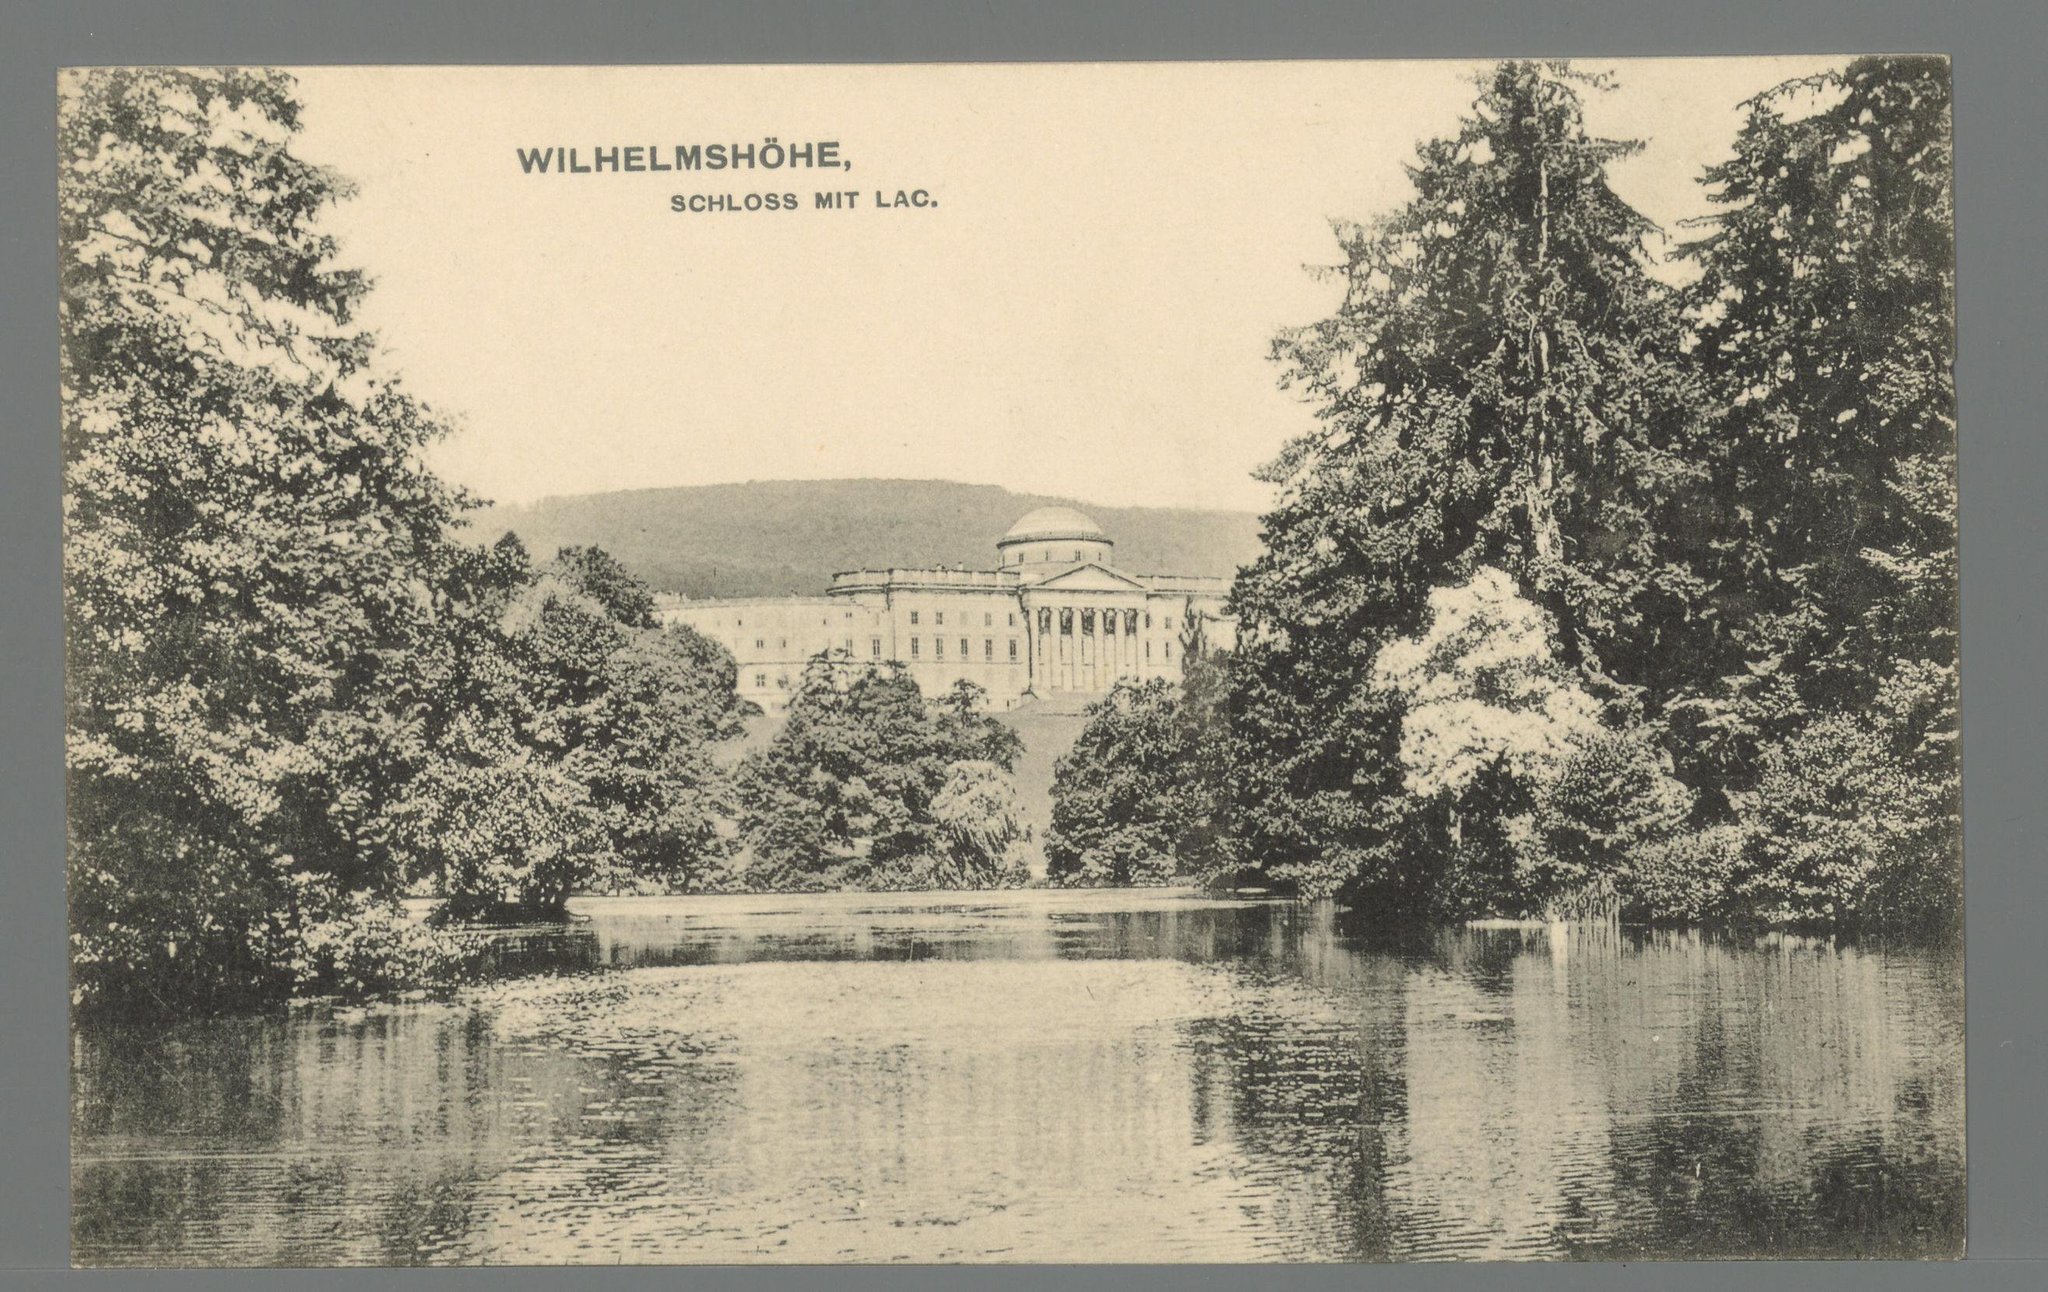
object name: ansichtkaart, prentbriefkaart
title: Wilhelmshöhe, Schloss mit Lac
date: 1908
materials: cardboard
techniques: photograph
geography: kassel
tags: castle, lake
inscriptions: date